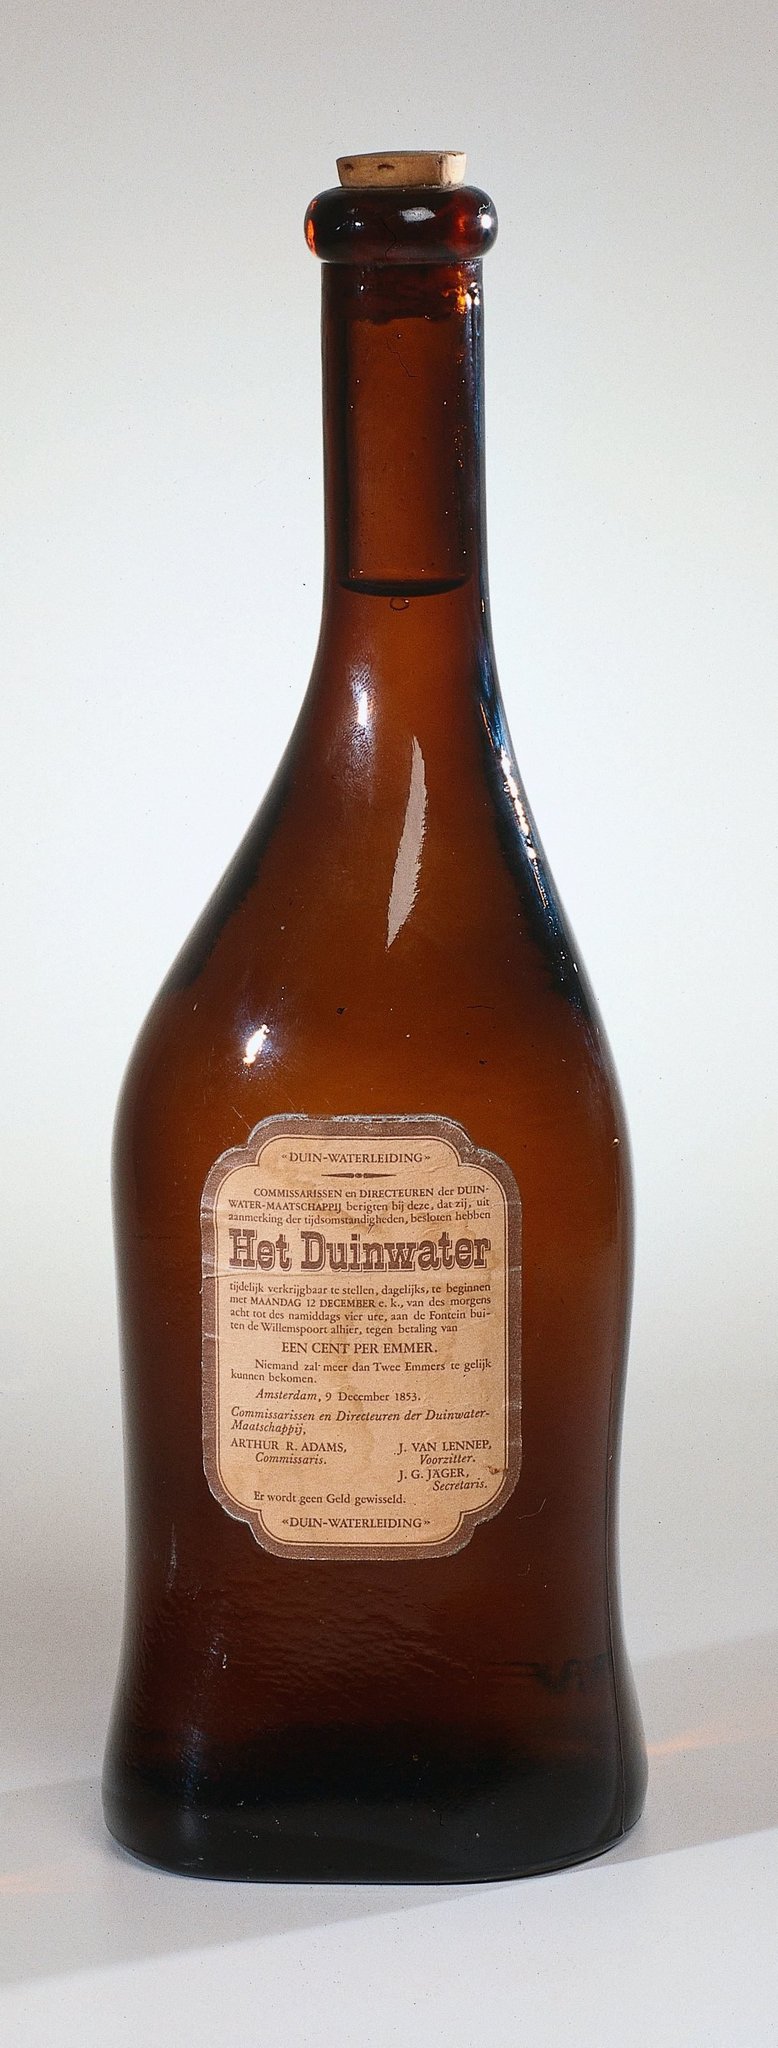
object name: bottle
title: Fles duinwater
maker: jan ketting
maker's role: industrieel ontwerper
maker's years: 1941-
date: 1975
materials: cork, glass, liquid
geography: amsterdam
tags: amsterdam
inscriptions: label: ‘<< DUIN-WATERLEIDING >> / COMMISSARISSEN en DIRECTEUREN der DUIN- / WATER-MAATSCHAPPIJ berigten bij deze, dat zij, uit / aanmerking der tijdsomstandigheden, besloten hebben / Het Duinwater (groot corps) / tijdelijk verkrijgbaar te stellen, dagelijks, te beginnen / met MAANDAG 12 DECEMBER e.k., van des morgens / acht tot des namiddags vier ure, aan de Fontein bui-/ten de Willemspoort alhier, tegen betaling van / EEN CENT PER EMMER. / Niemand zal meer dan Twee Emmers te gelijk / kunnen bekomen. / Amsterdam, (cursief) 9 December 1853. Commissarissen en Directeuren der Duinwater- / Maatschappij, (cursief)/ ARTHUR R. ADAMS, J. VAN LENNEP, / Commissaris. Voorzitter. (cursief) / J.G. JÄGER / Secretaris. (cursief) / Er wordt geen Geld gewisseld. / << DUIN-WATERLEIDING >>’, mark: ‘1. F; slecht leesbaar: MOD DEP (??).’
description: Asymetrische bruinglazen fles met enigszins getailleerde buik, slanke uit het midden staande hals en ronde mond. De fles heeft links en rechts een naad en een kleine ziel. De fles, gevuld met water, is afgesloten met een kurk. Middenvoor: rechthoekig etiket met bruine rand en ingesnoerde hoeken. Het etiket is in bruin bedrukt met een tekst uit een krantenadvertentie van 9 december 1853, waarin de verkoop van duinwater onder de aandacht wordt gebracht.